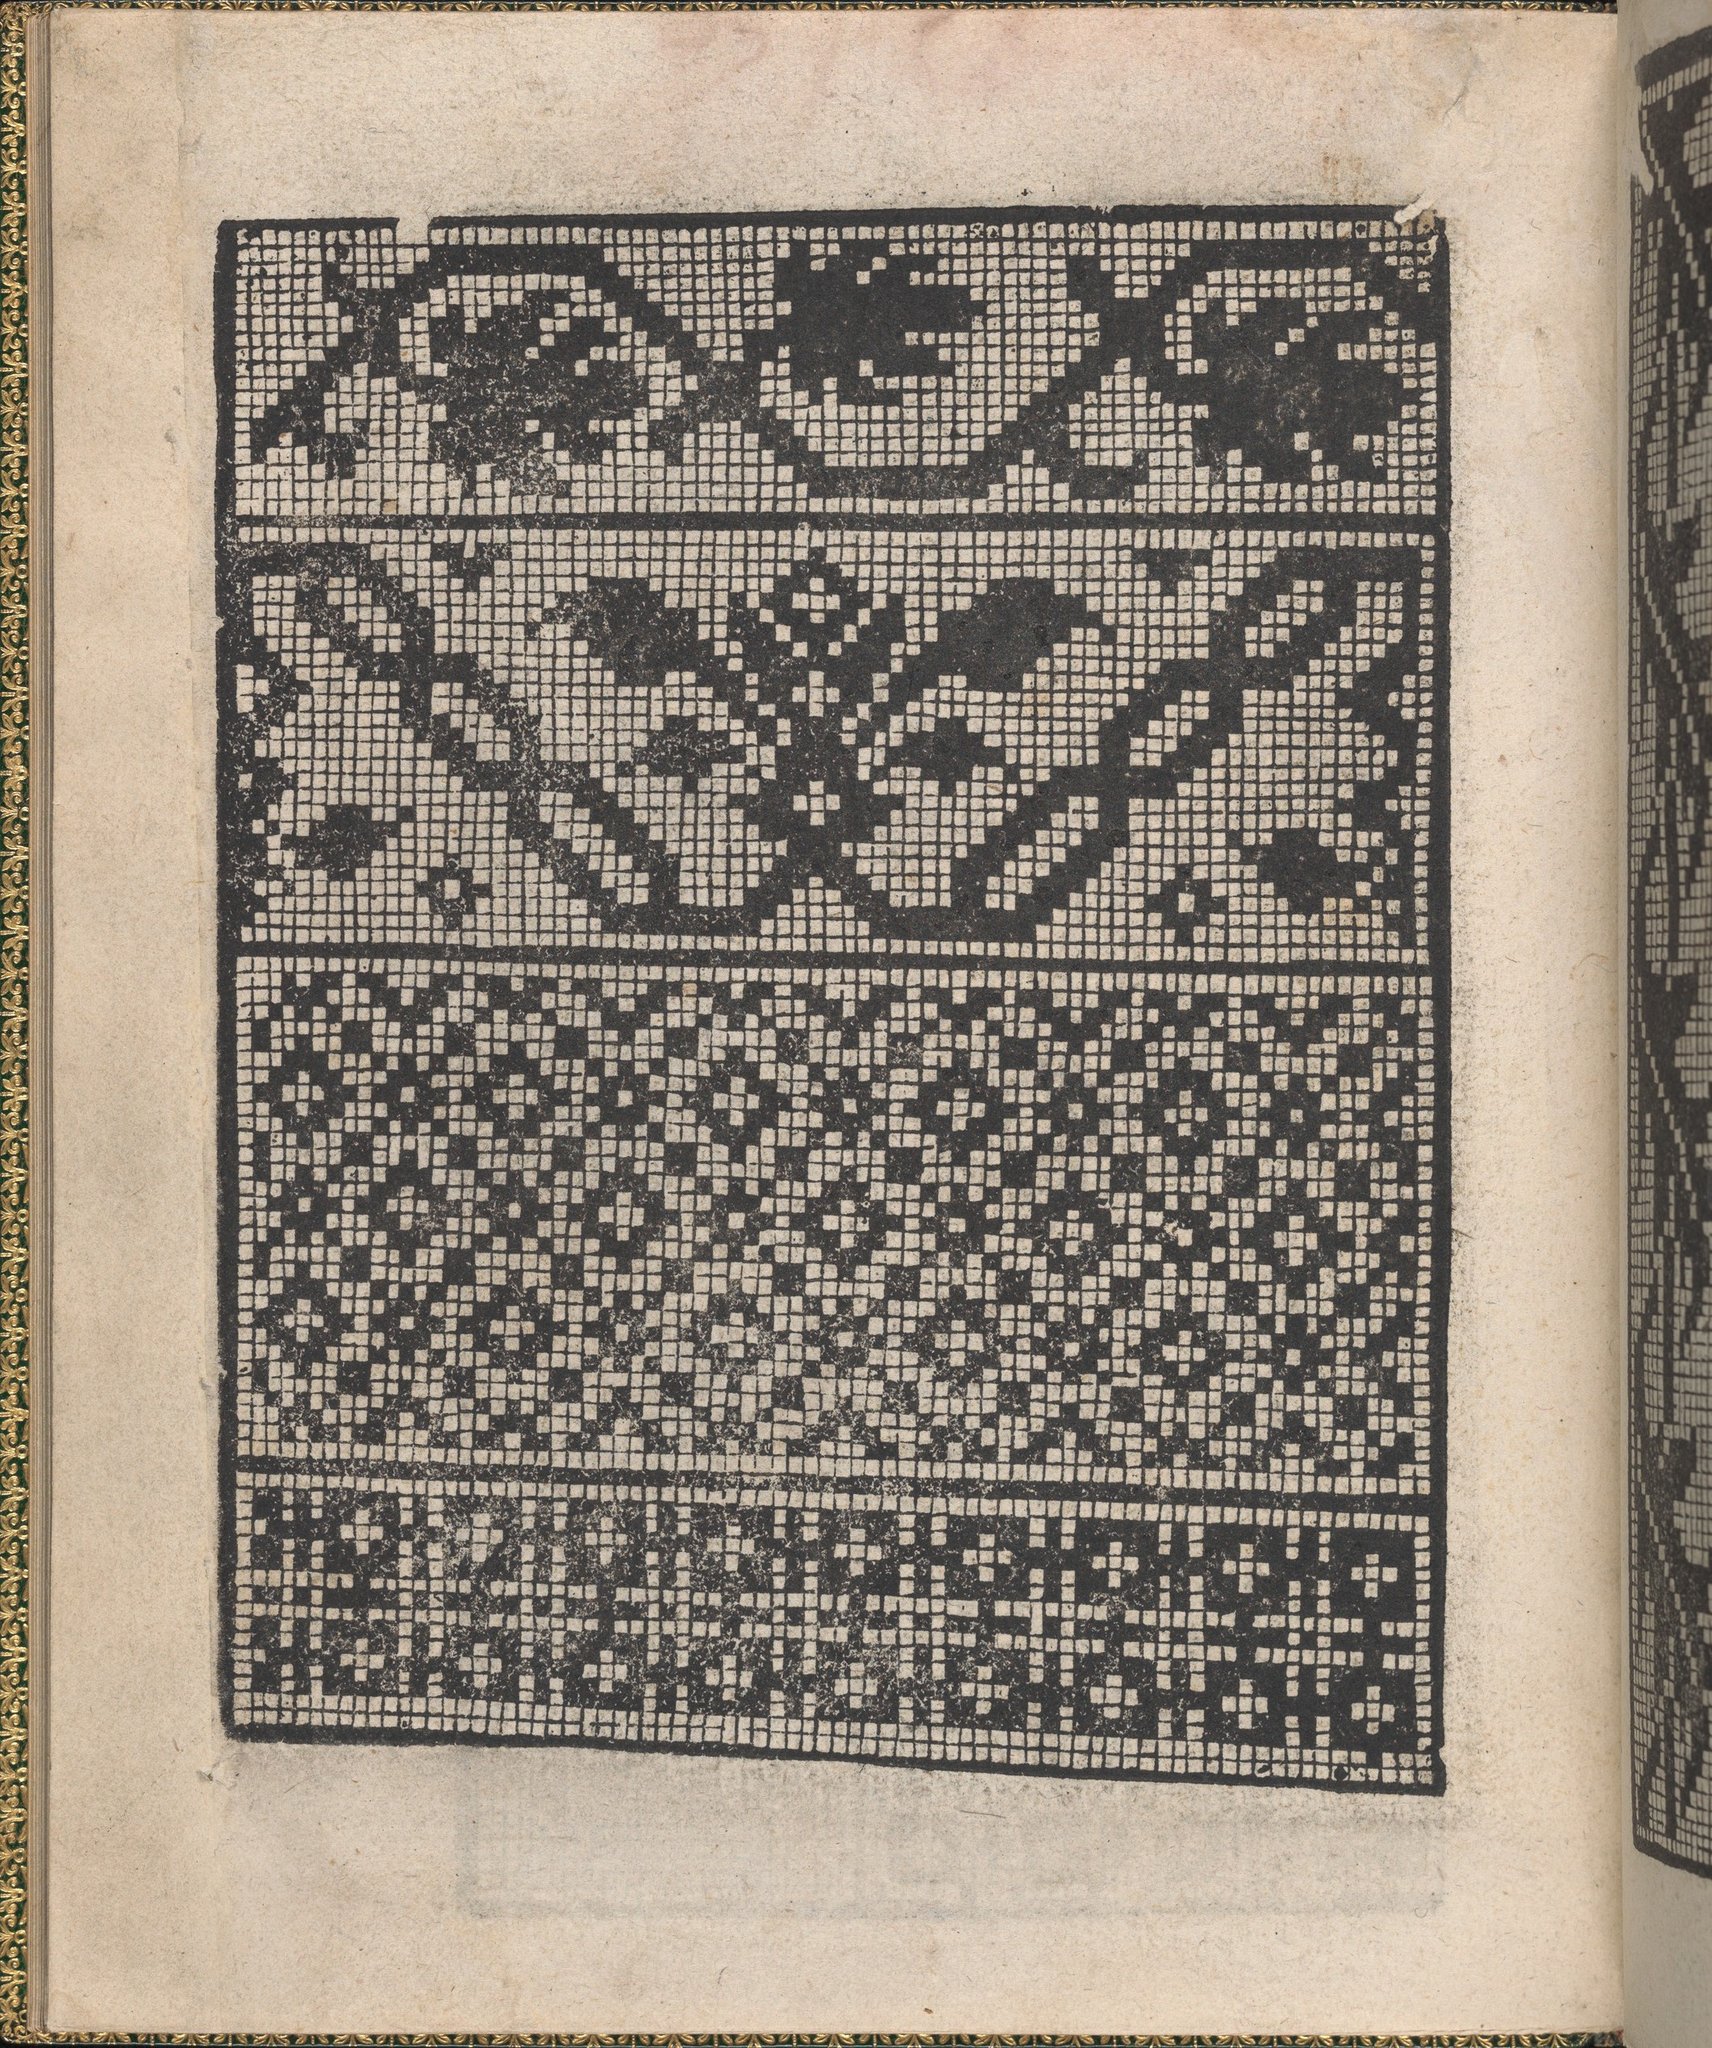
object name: book print ornament architecture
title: Ornamento delle belle & virtuose donne, page 15 (verso)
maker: matteo pagano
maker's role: publisher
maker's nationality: italian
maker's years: 1515-1588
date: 1554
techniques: woodcut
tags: ornament